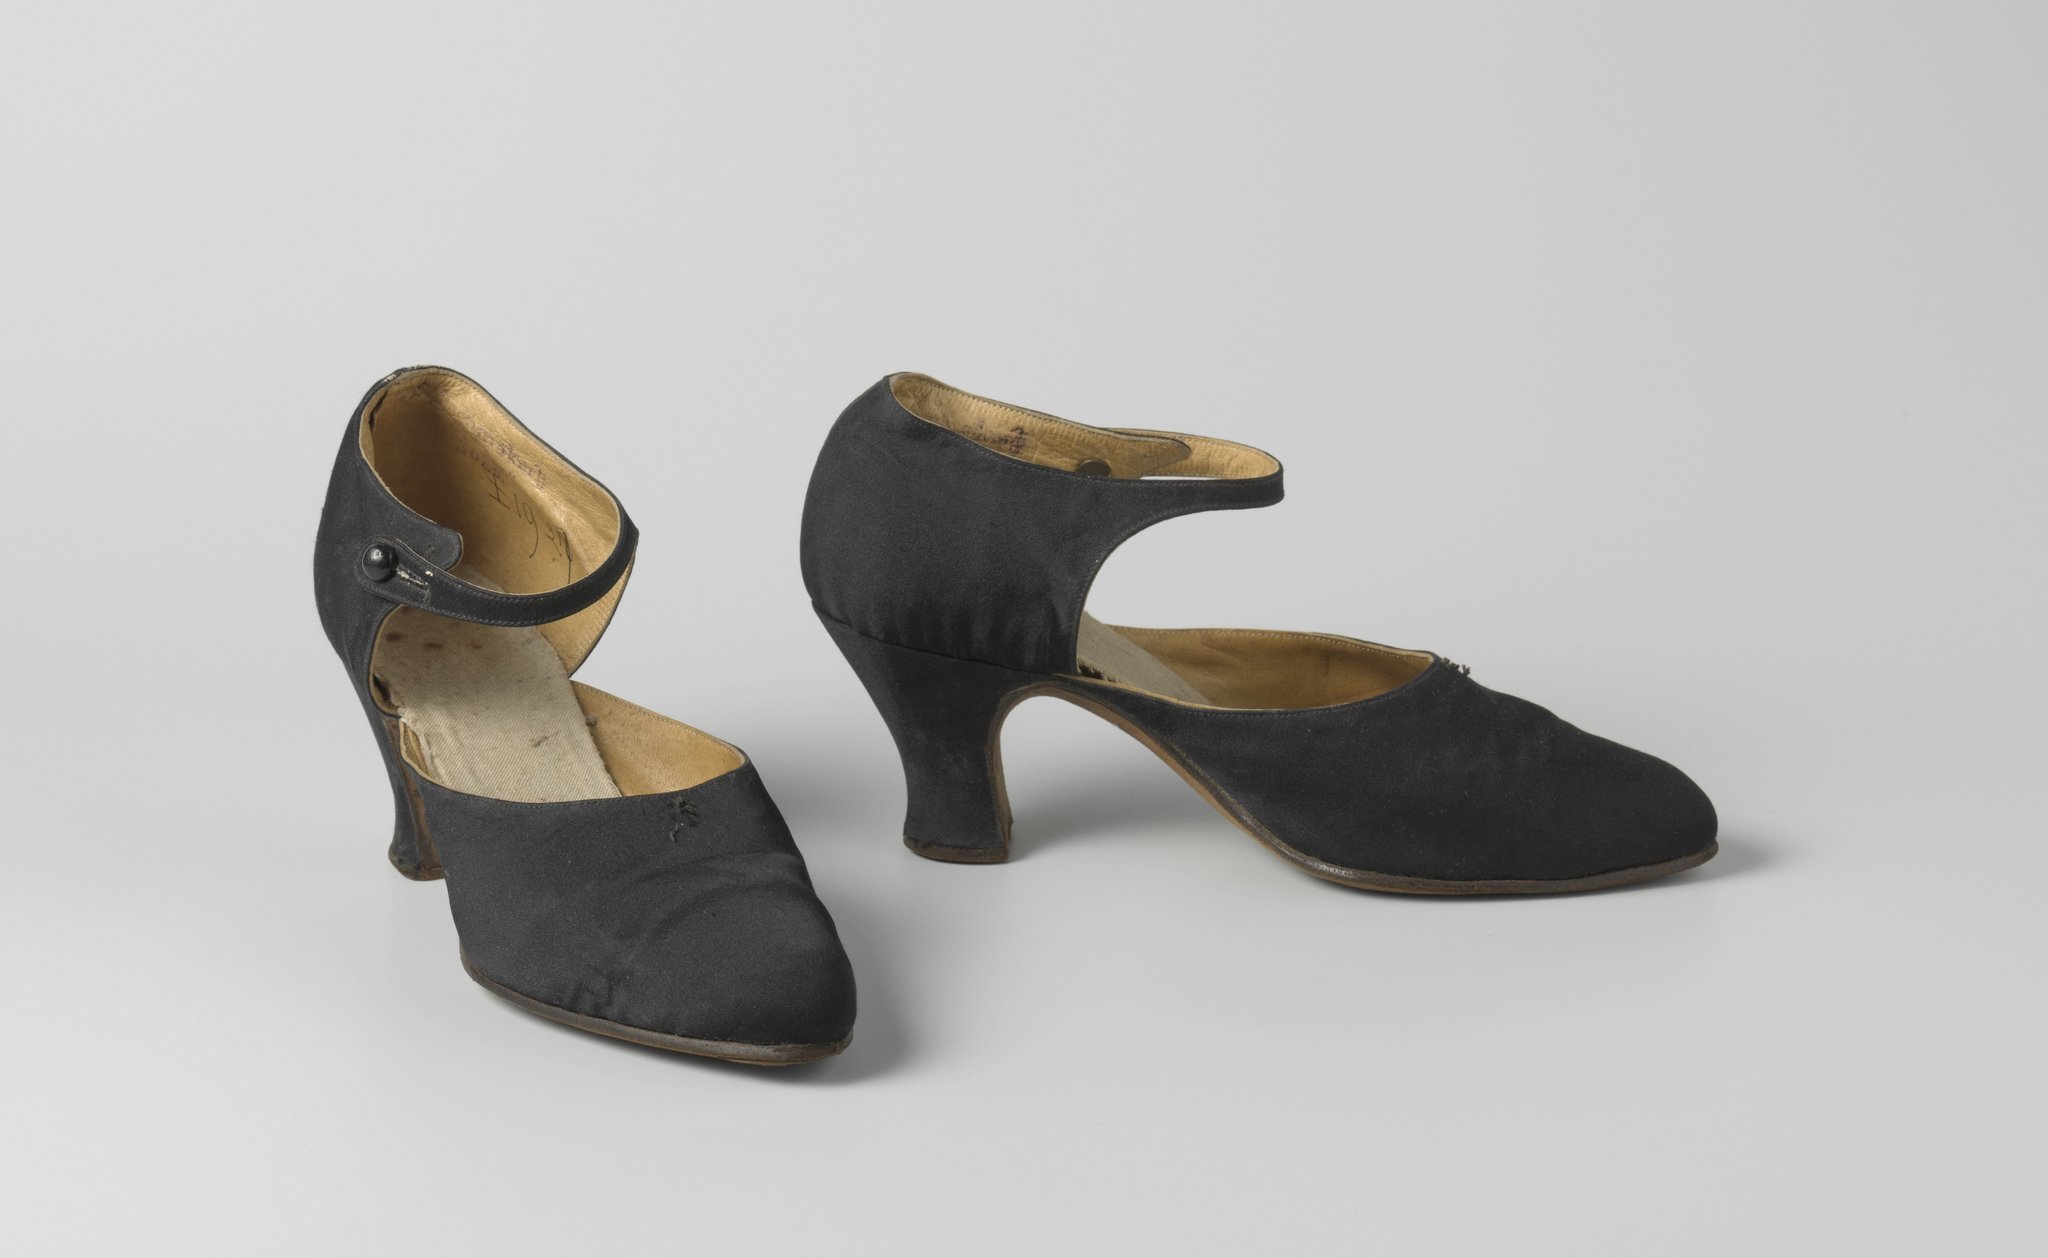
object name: mary jane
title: Damesschoen van zwart satijn met enkelband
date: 1920-1925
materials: cotton, iron, leather, linen, metal, plastic, silk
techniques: casting, tanning, weave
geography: netherlands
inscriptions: size: ‘36 // 1’, company name: ‘Schoenmakerij // "De Zon" // SOLO.’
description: Damesschoen van zwart satijn met enkelband. Model: Afgeronde spitse neus, één voorblad en twee zijbladen. De uitsnijding van het voorblad loopt tot boven aan het geleng. De zijbladen beginnen boven aan het geleng. De zijbladen lopen recht naar boven. Het rechterzijblad loopt uit in een enkelband. Op het linkerzijblad is, via een metalen oog, een zwarte kunststof knoop bevestigd. De voorkant van de hak loopt in een afgeronde hoek recht naar beneden. De zijkant en achterkant van de smalle hak zijn getailleerd en bekleed met zwart satijn. De hak heeft een donkerbruine rand leer van het achterlapje. Leren achterlapje met zeven spijkers aan de hak vastgeslagen en leren zool. Zijbladen gevoerd met mosterdkleurig leer. Voorblad gevoerd met ivoorwit linnen, langs de uitsnijding is het voorblad gevoerd met een band mosterdkleurig leer. De binnenzool is van beige geribd katoen. Middenvoor de uitsnijding op de voorvoet zijn draadrestjes te zien mogelijk van een versiering.